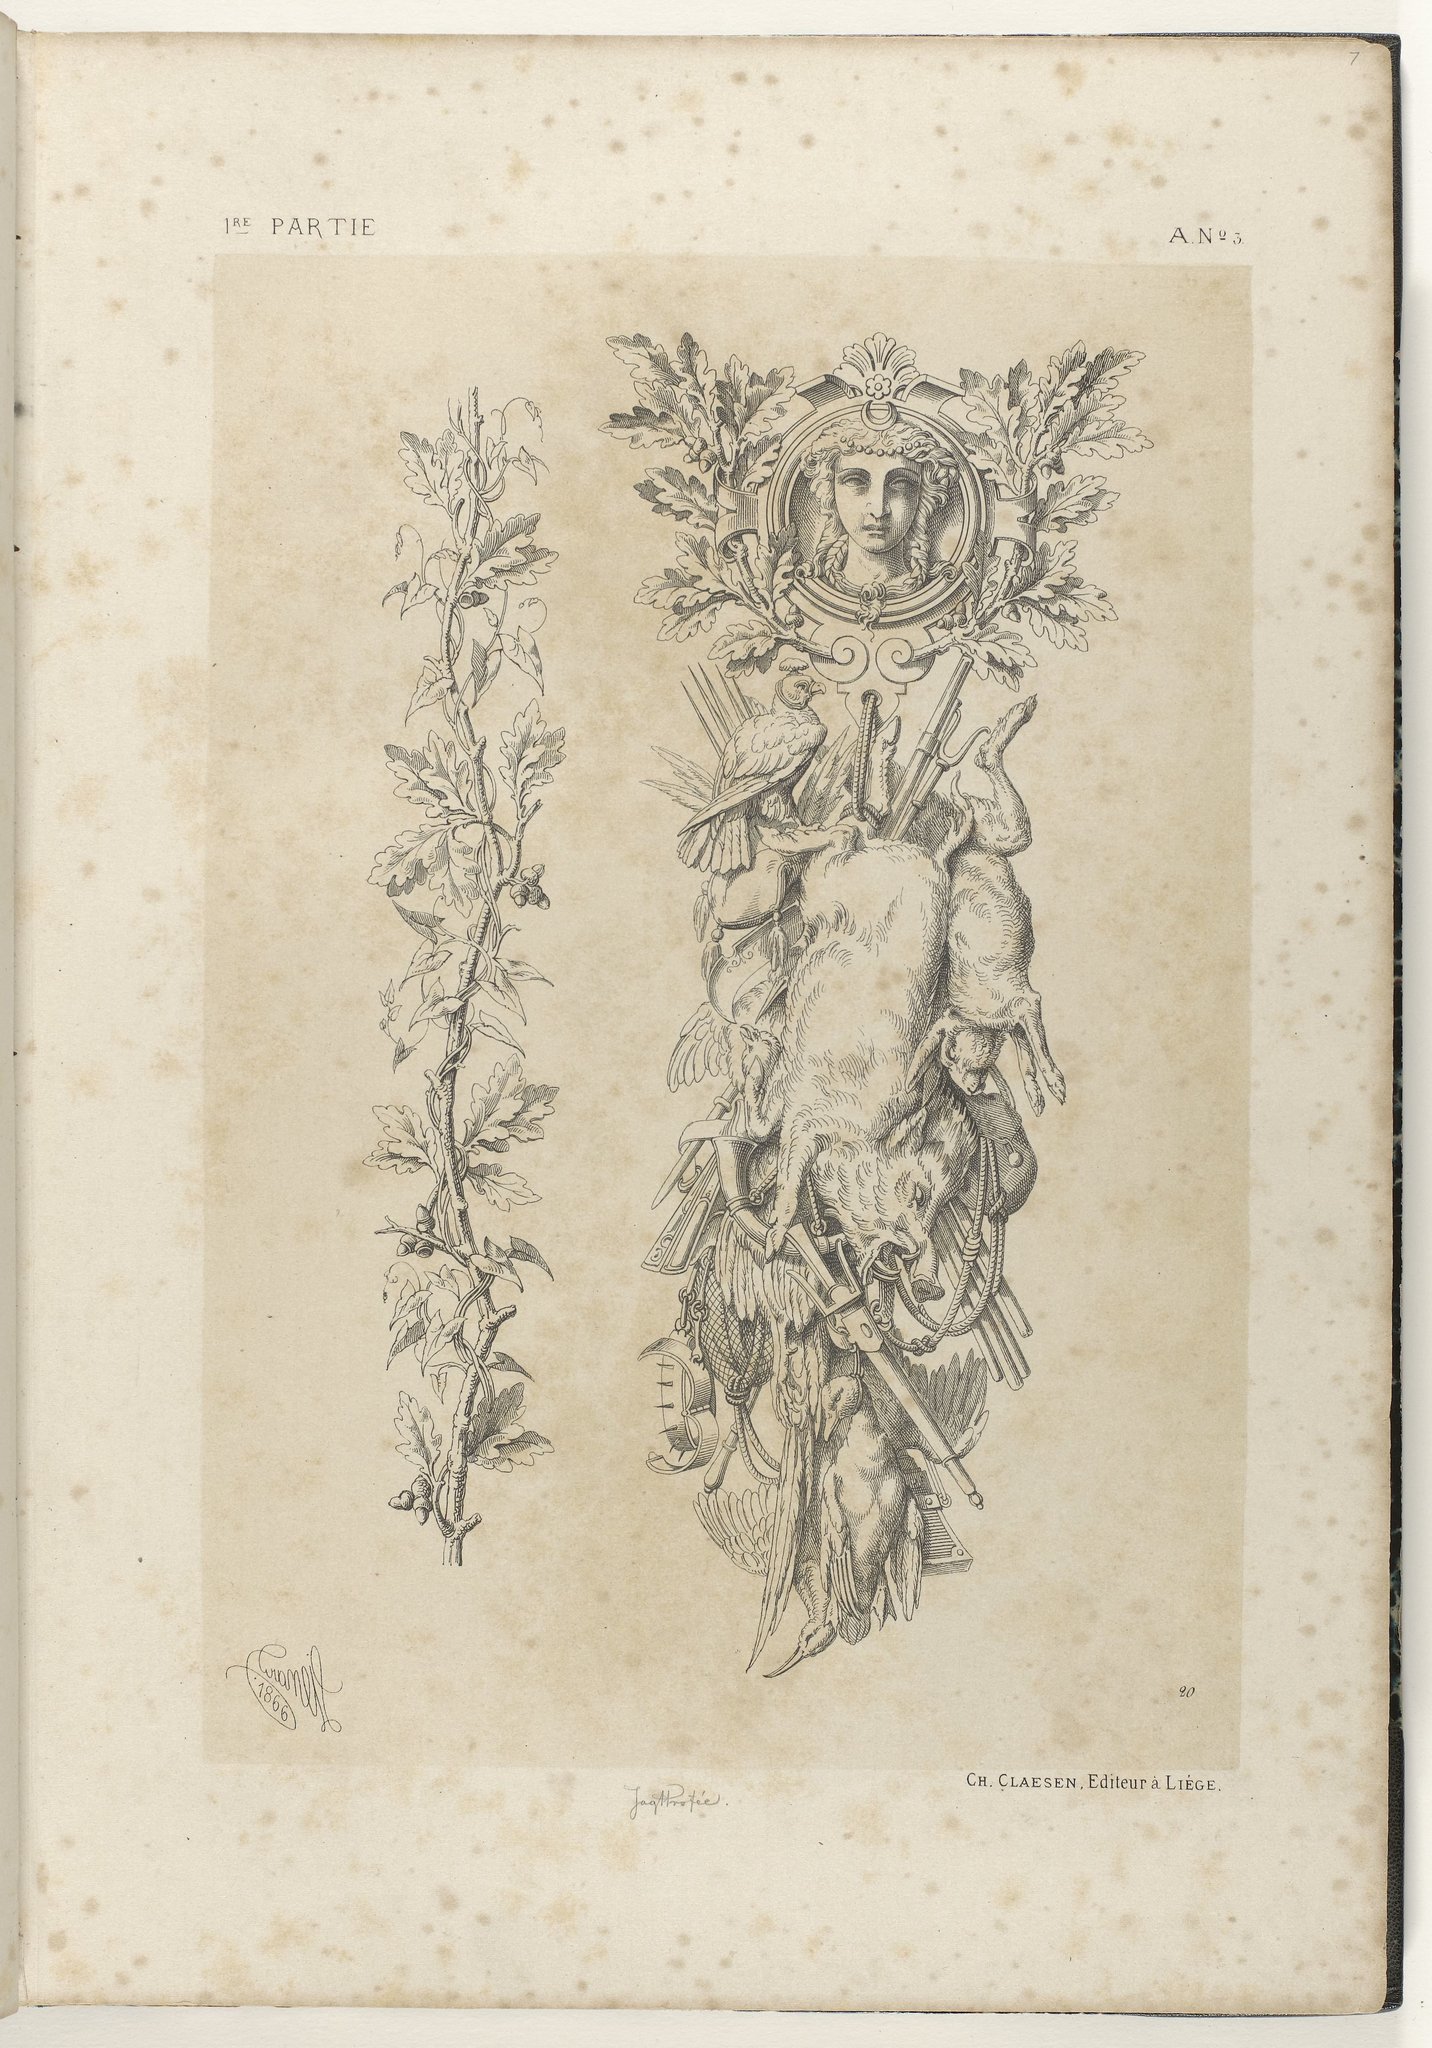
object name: print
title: Eikentak en jachttrofee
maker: michel liénard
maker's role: print maker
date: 1866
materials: paper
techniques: tone lithography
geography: liège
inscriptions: annotation: ‘Jagttrofeé.’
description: Links een stengel met eikels en eikenbladeren, rechts een cartouche met het hoofd van Diana waaronder een trofee hangt. Linksboven: 1re partie, rechtsboven: A. N° 3, rechtsonder: 20.